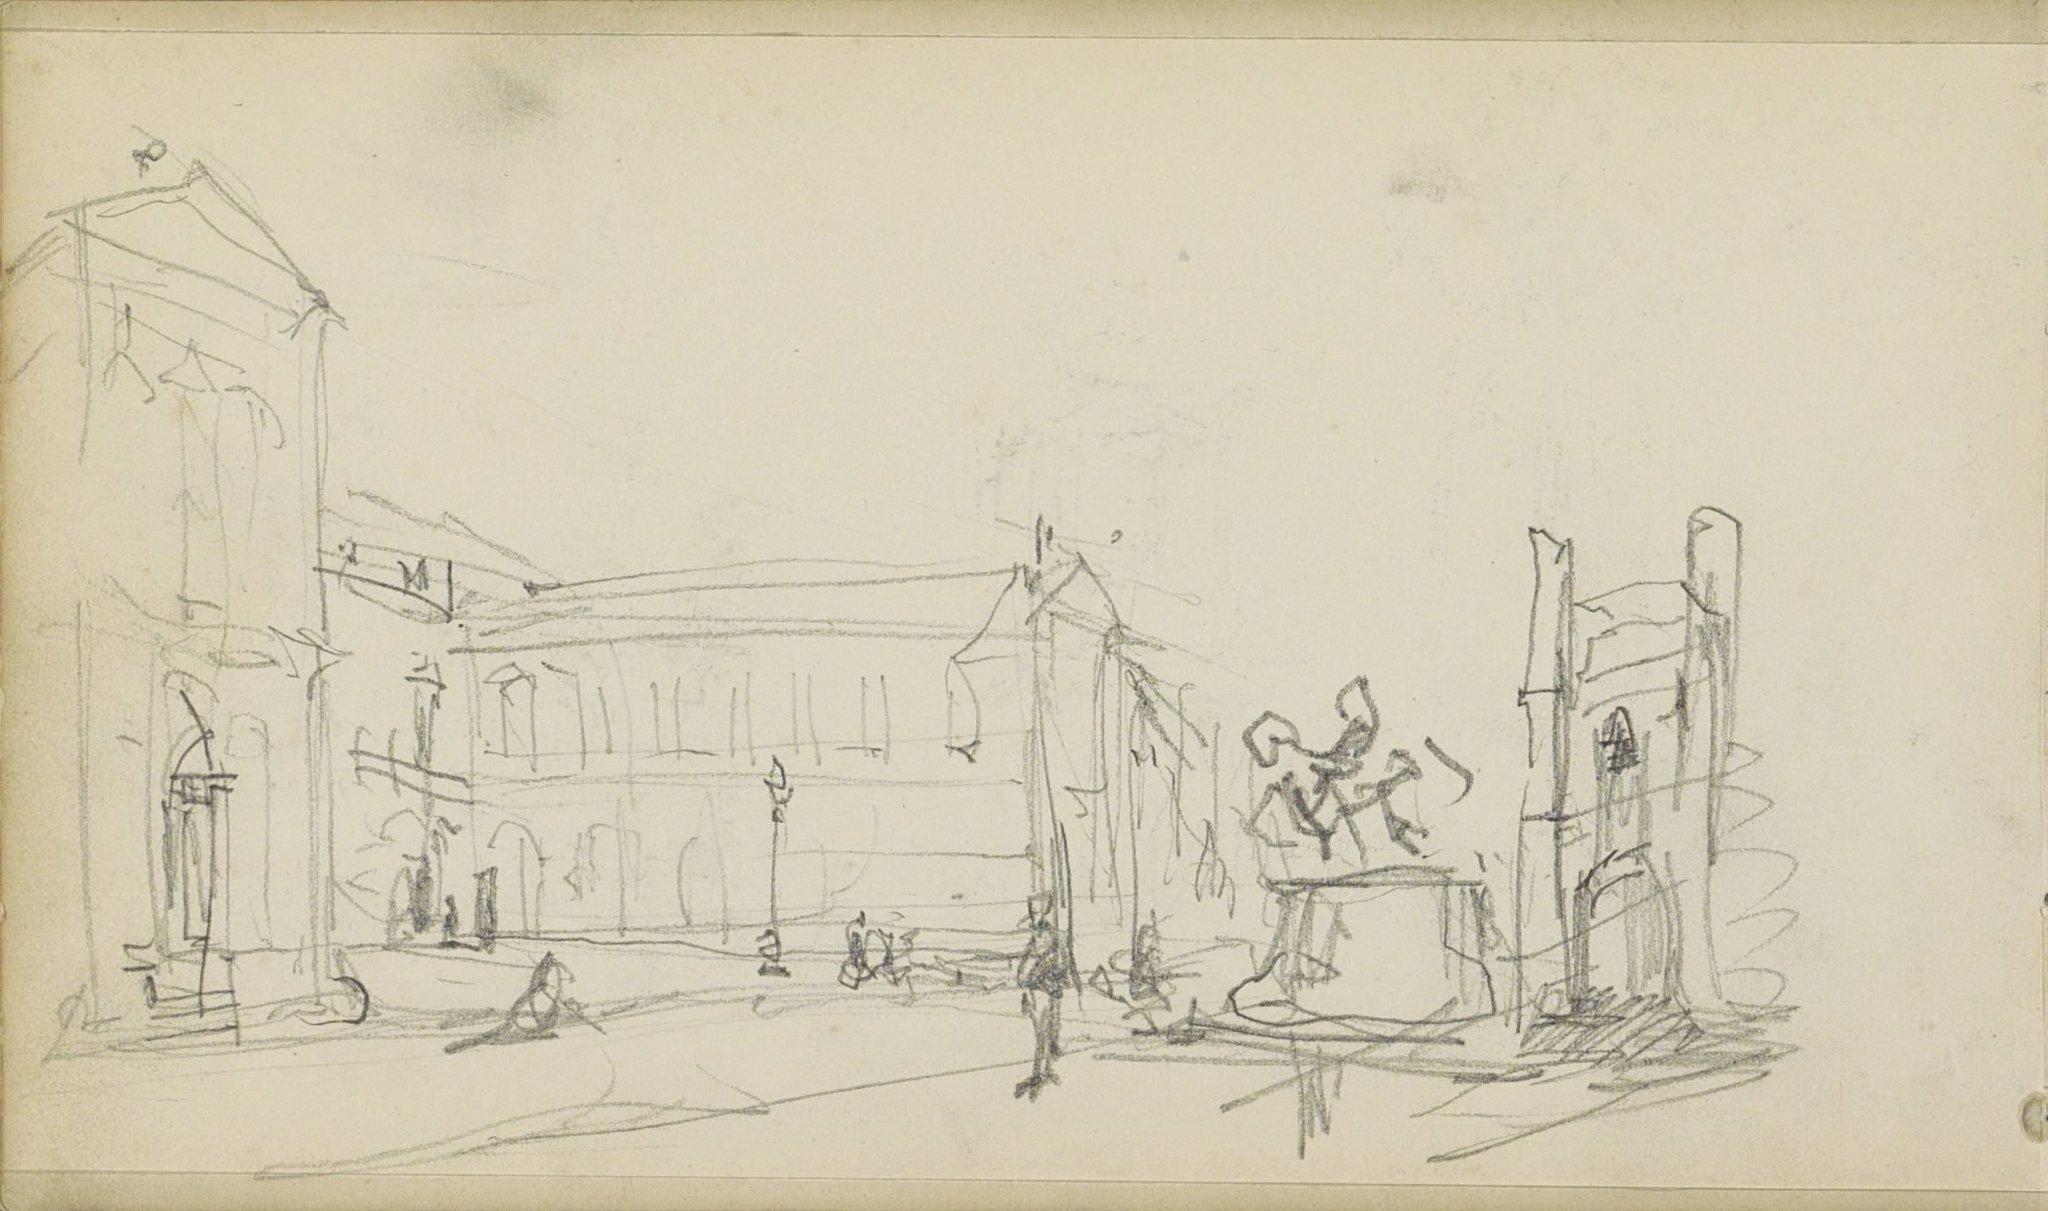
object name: sketchbook leaf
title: Paleis Noordeinde met het ruiterstandbeeld van Willem van Oranje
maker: johannes bosboom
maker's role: draughtsman, painter, print maker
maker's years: 1817-1891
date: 1845-1891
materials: paper, pencil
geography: the hague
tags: monument, statue, hôtel, i.e. small palace in city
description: Blad 2 verso uit een schetsboek met 46 bladen.